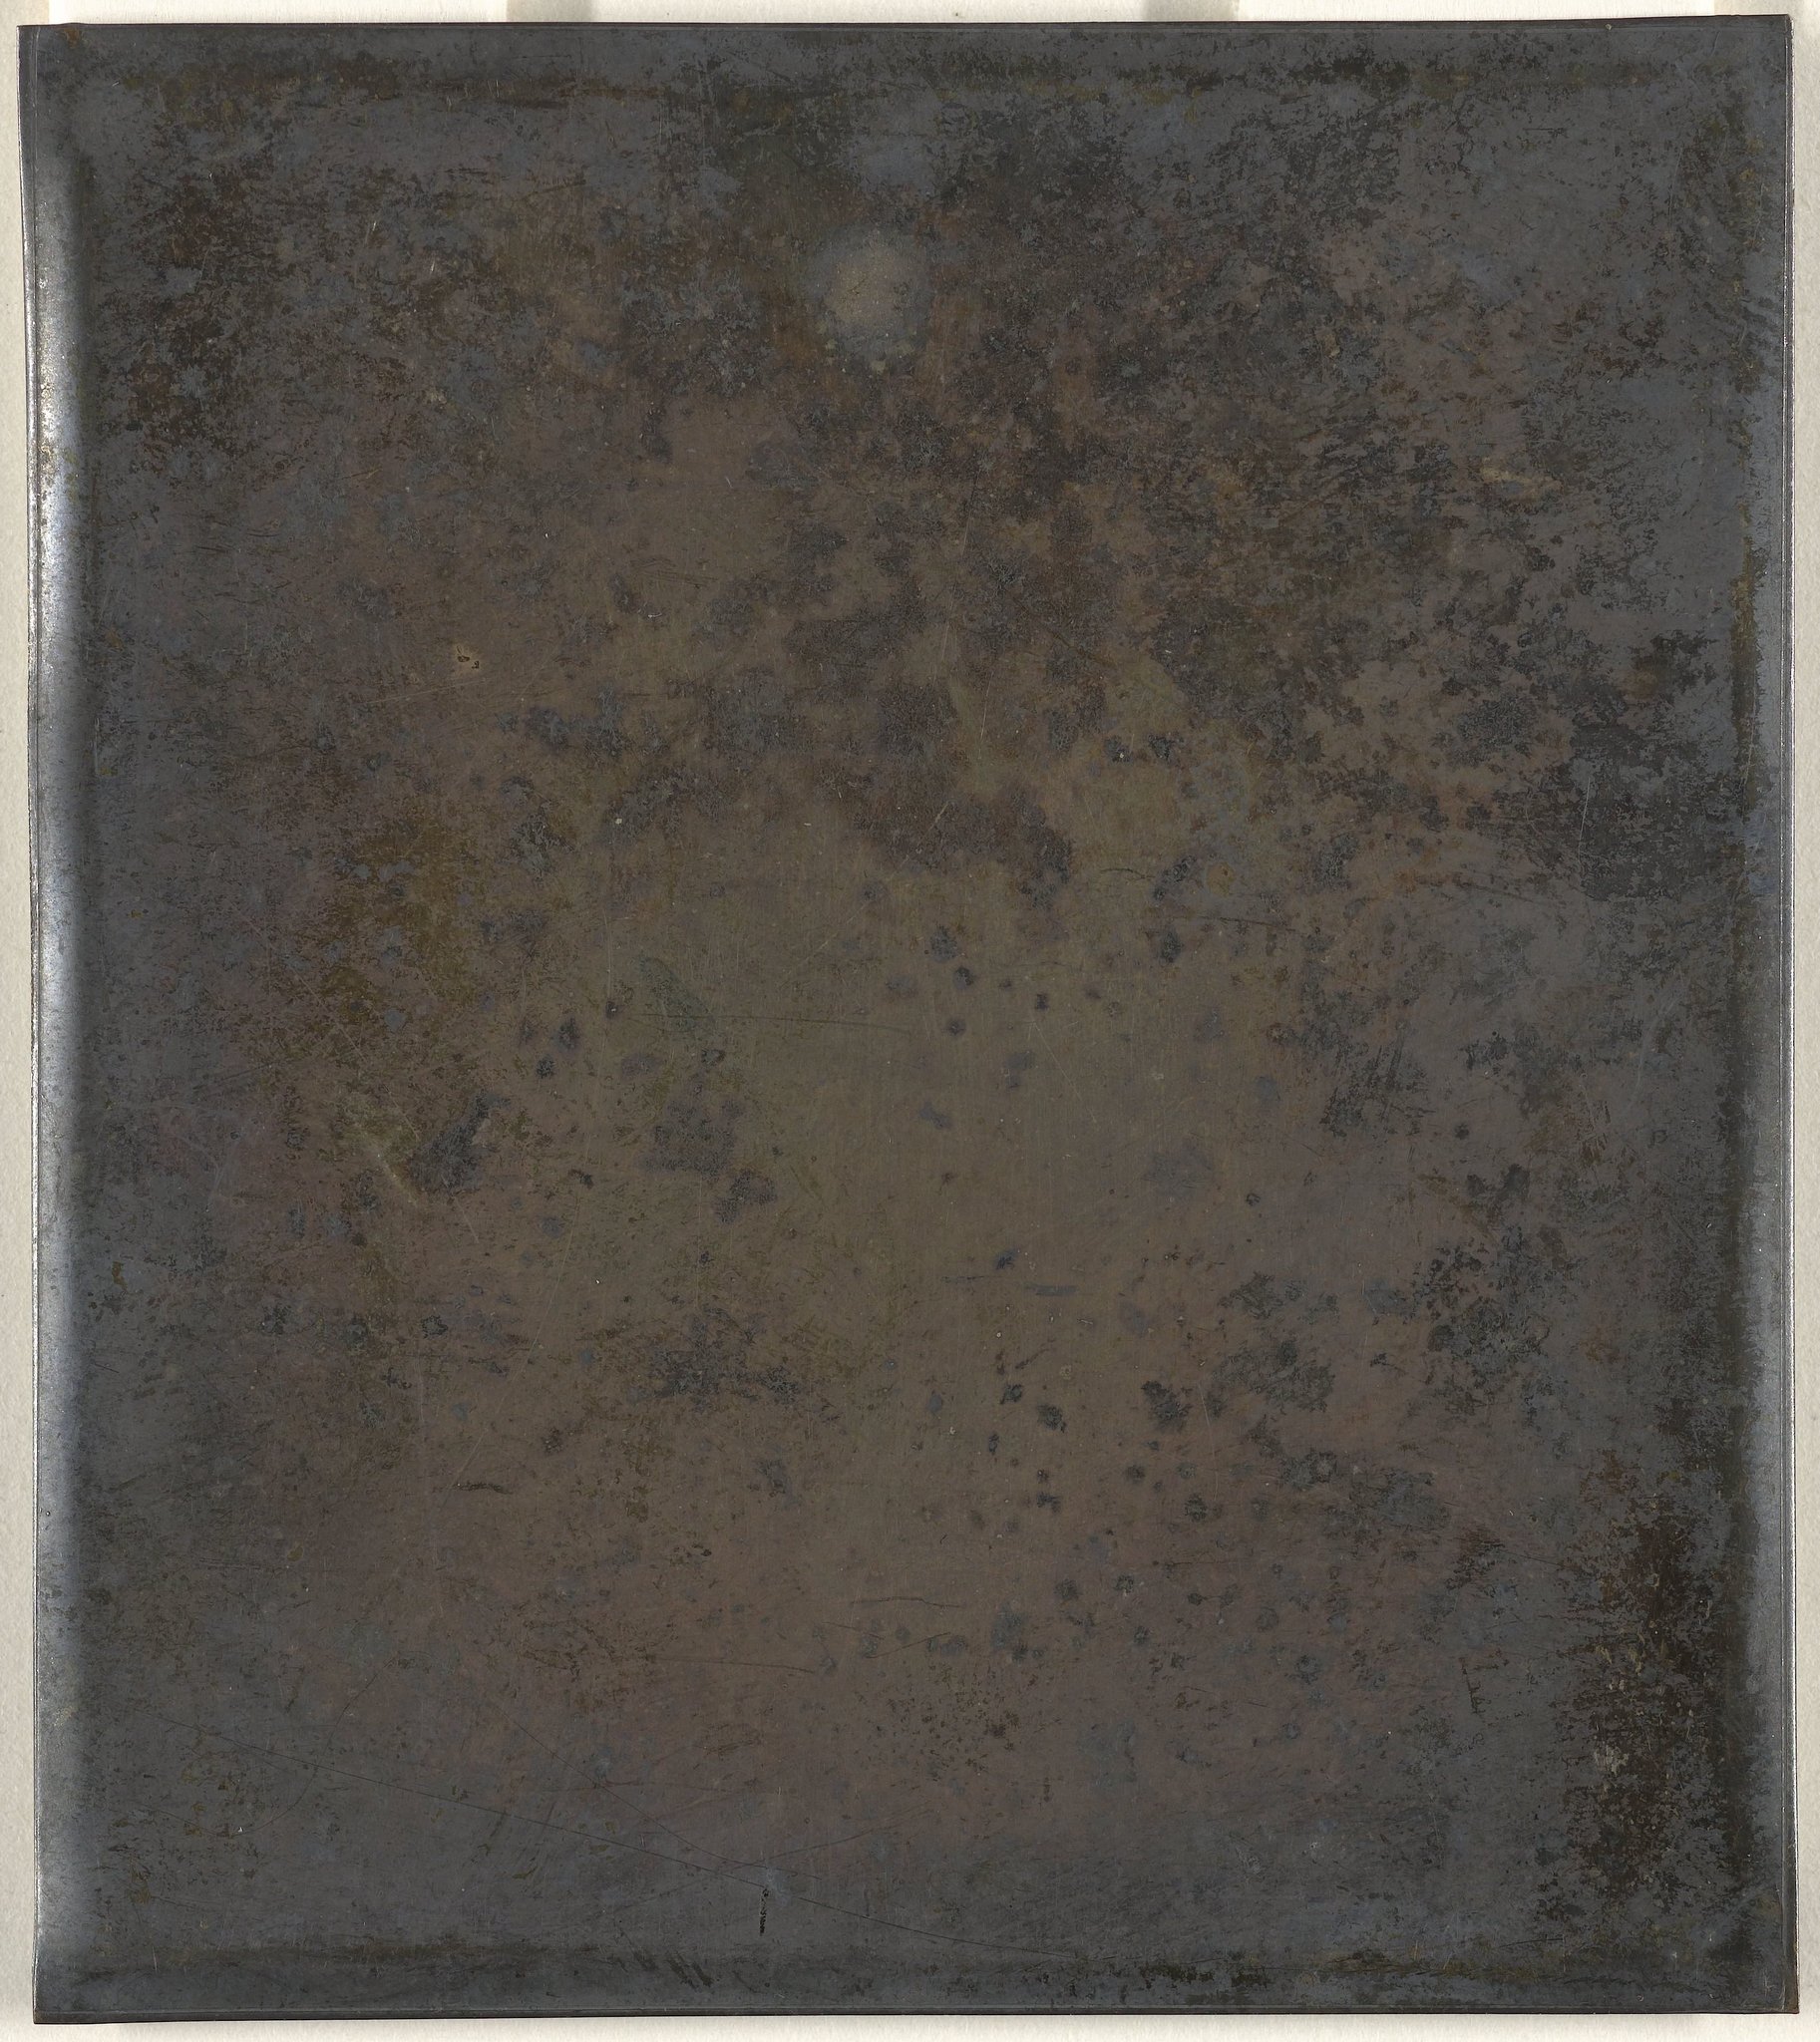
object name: photograph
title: Gecorrodeerde daguerreotypieplaat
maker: Anonymous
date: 1839-1855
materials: copper, silver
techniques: daguerreotype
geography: netherlands